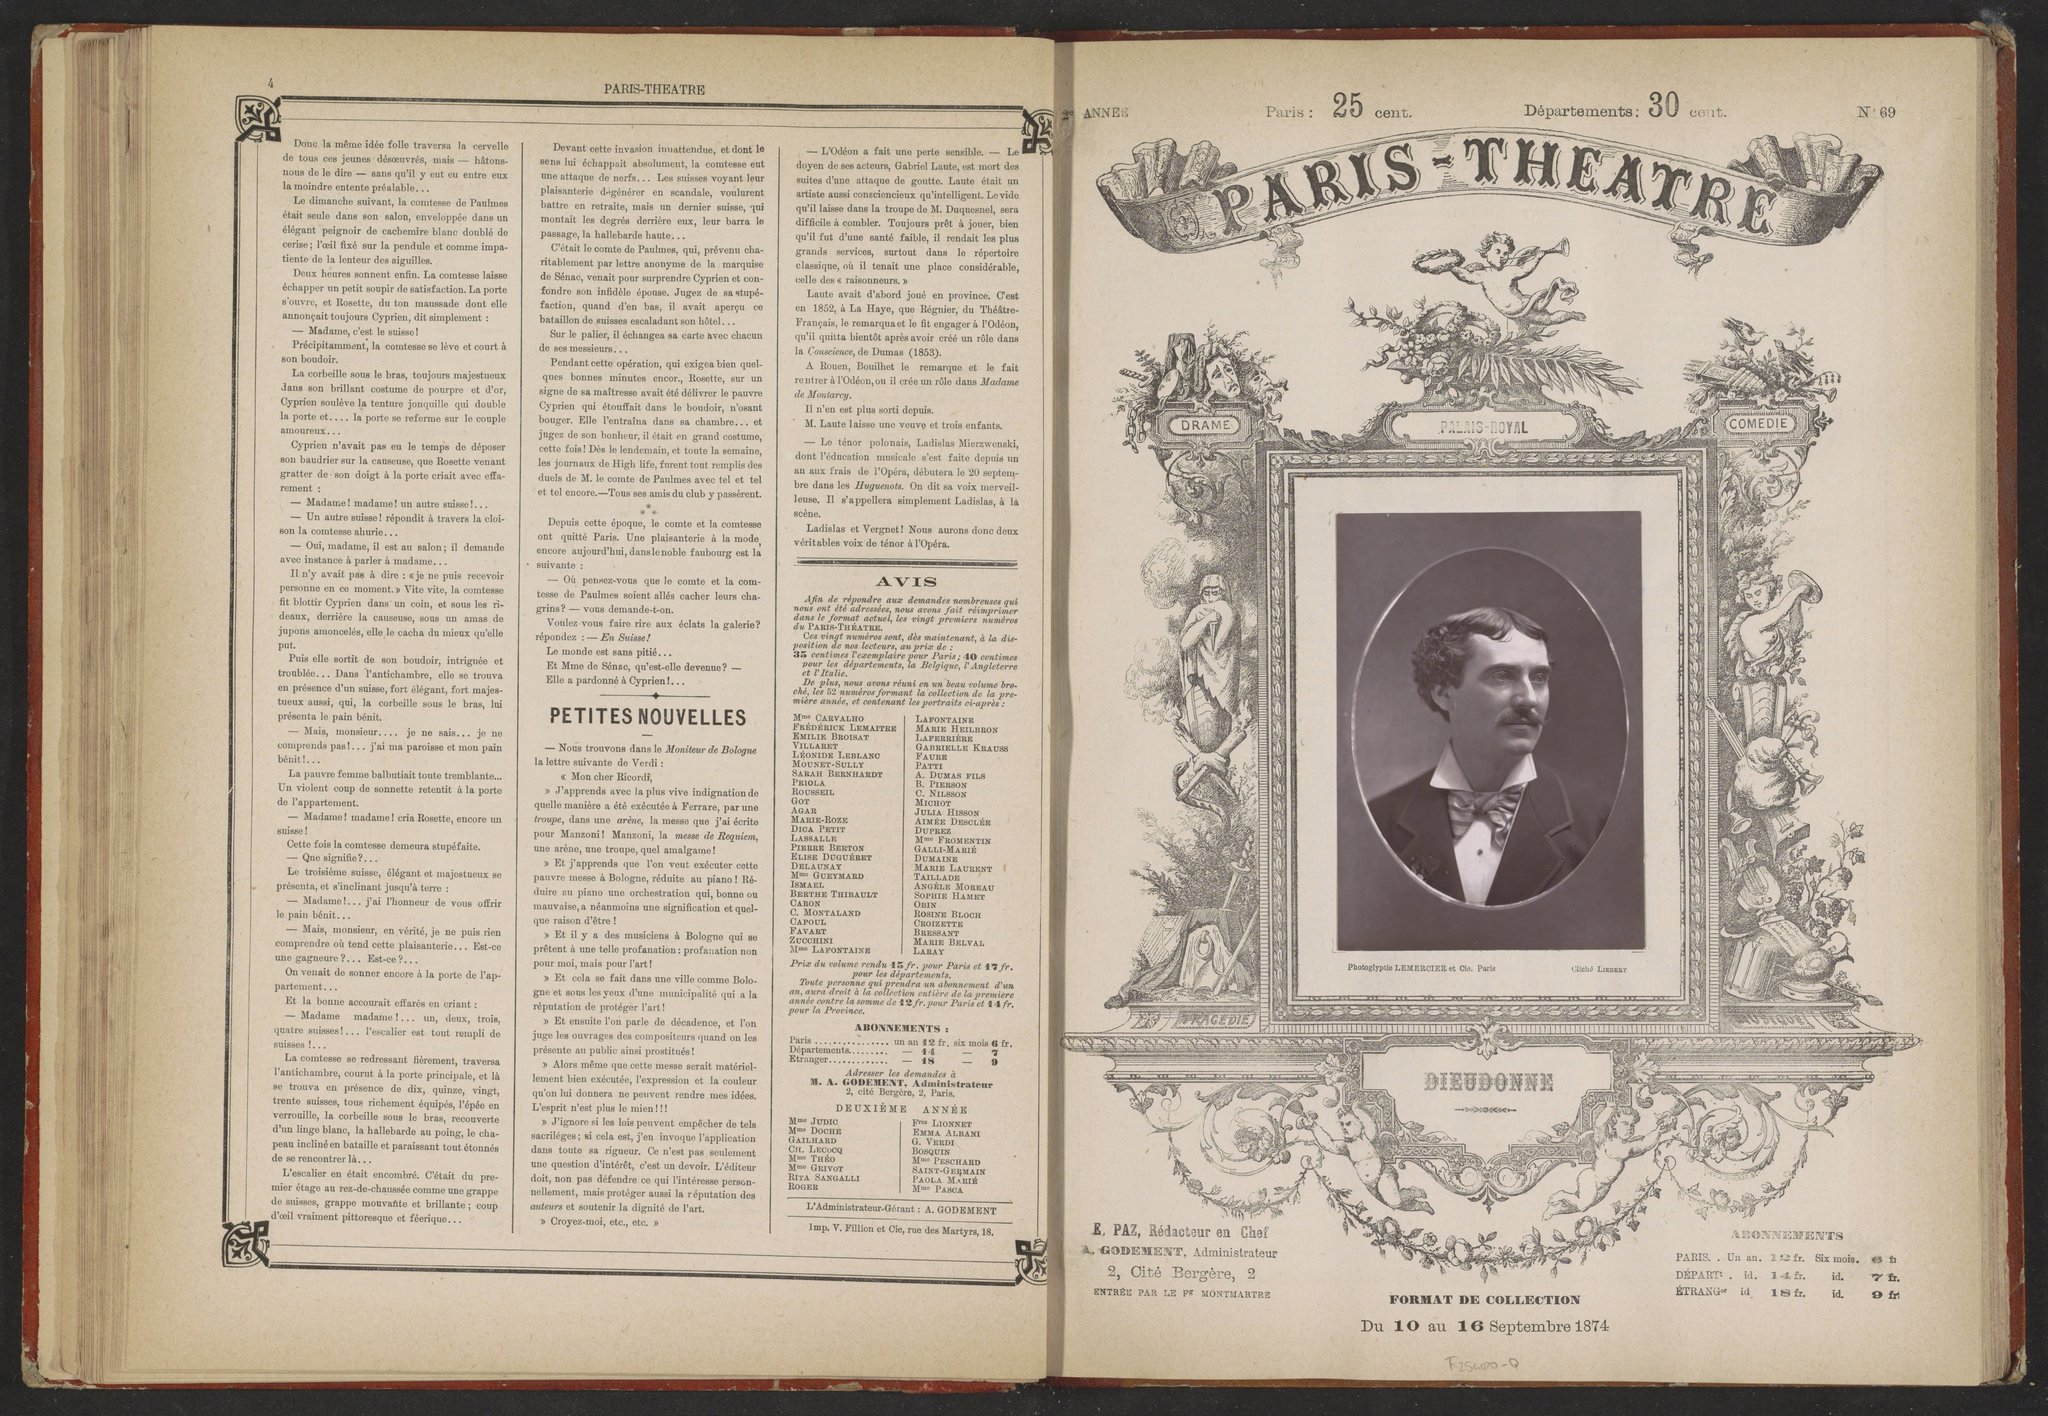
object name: photomechanical print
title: Dieudonne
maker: alphonse-justin liébert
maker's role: fotograaf, marinier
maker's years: 1827-1914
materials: paper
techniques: woodburytype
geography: paris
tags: portrait of actor, actress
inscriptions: inscription: ‘Du 10 au 16 Septembre 1874’, number: ‘No 69’